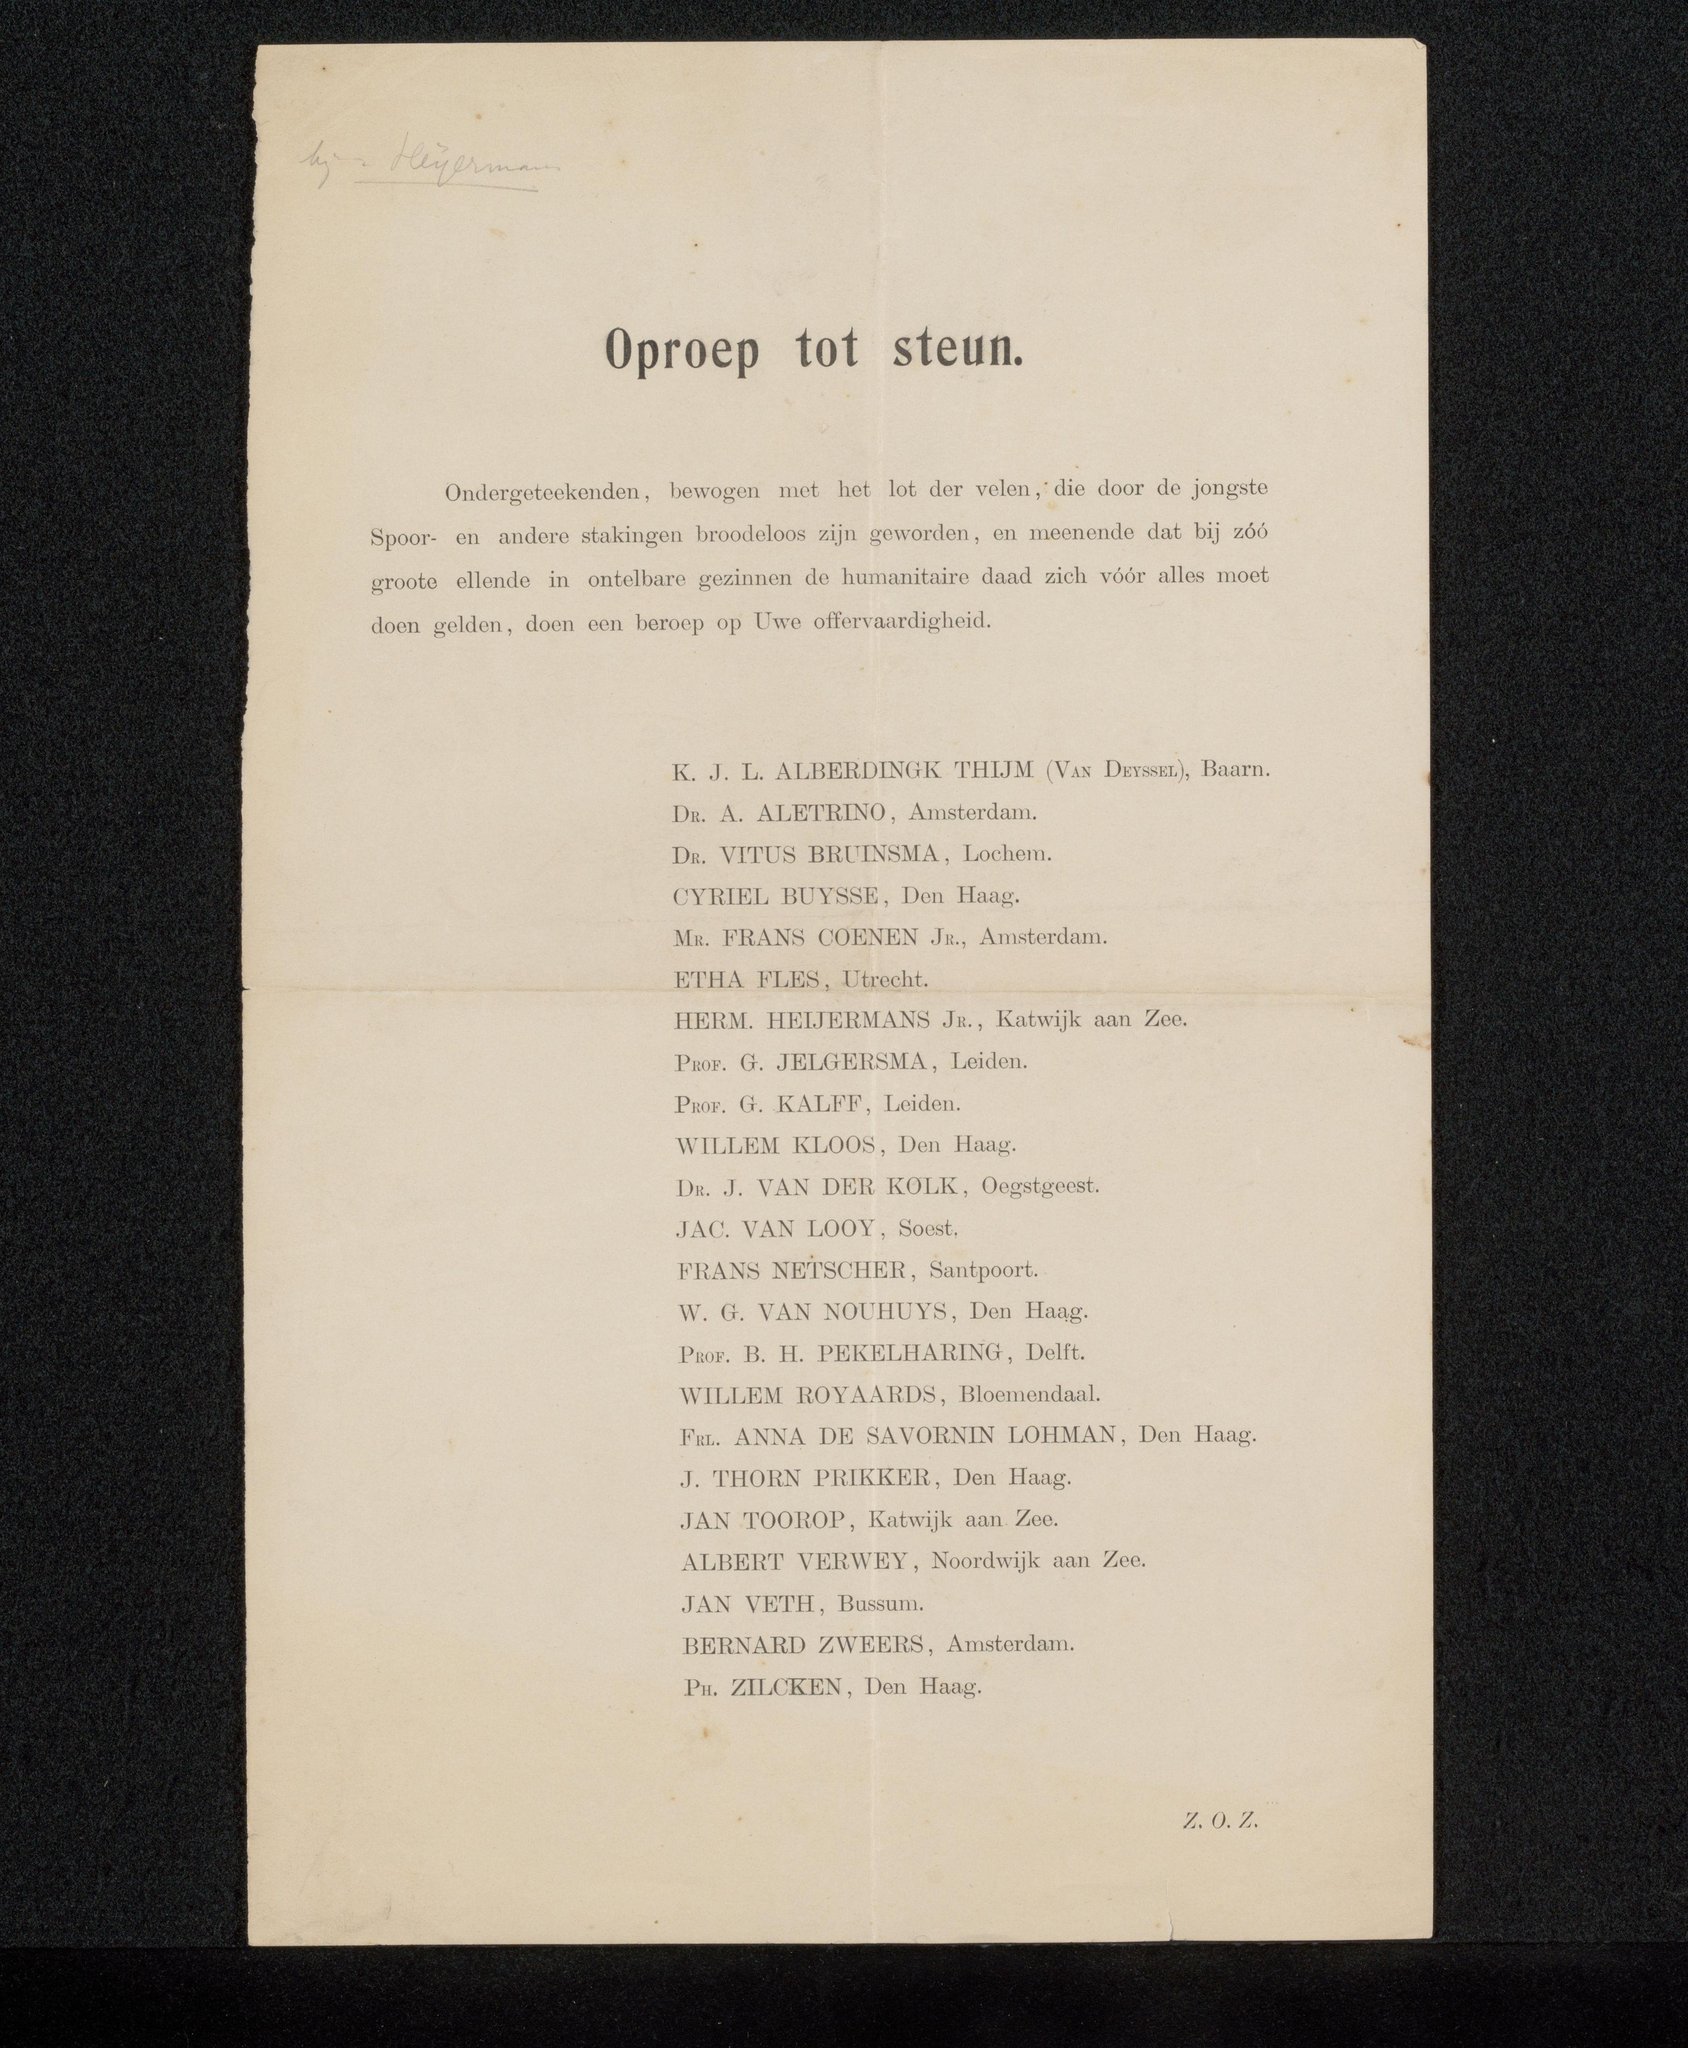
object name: brochure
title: Brochure uit archief Philip Zilcken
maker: Anonymous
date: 1903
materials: paper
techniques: printing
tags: rotterdam, herman heijermans, painter, draughtsman, philip zilcken, charitable works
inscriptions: collector's mark: ‘RPK’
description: Brochure is bewaard bij correspondentie van Herman Heijermans aan Philip Zilcken. Zilcken ontving eerder van Heijermans een oproep tot ondertekening van deze brochure (RP-D-1982-43-HEIJERMANS(H.)-1).